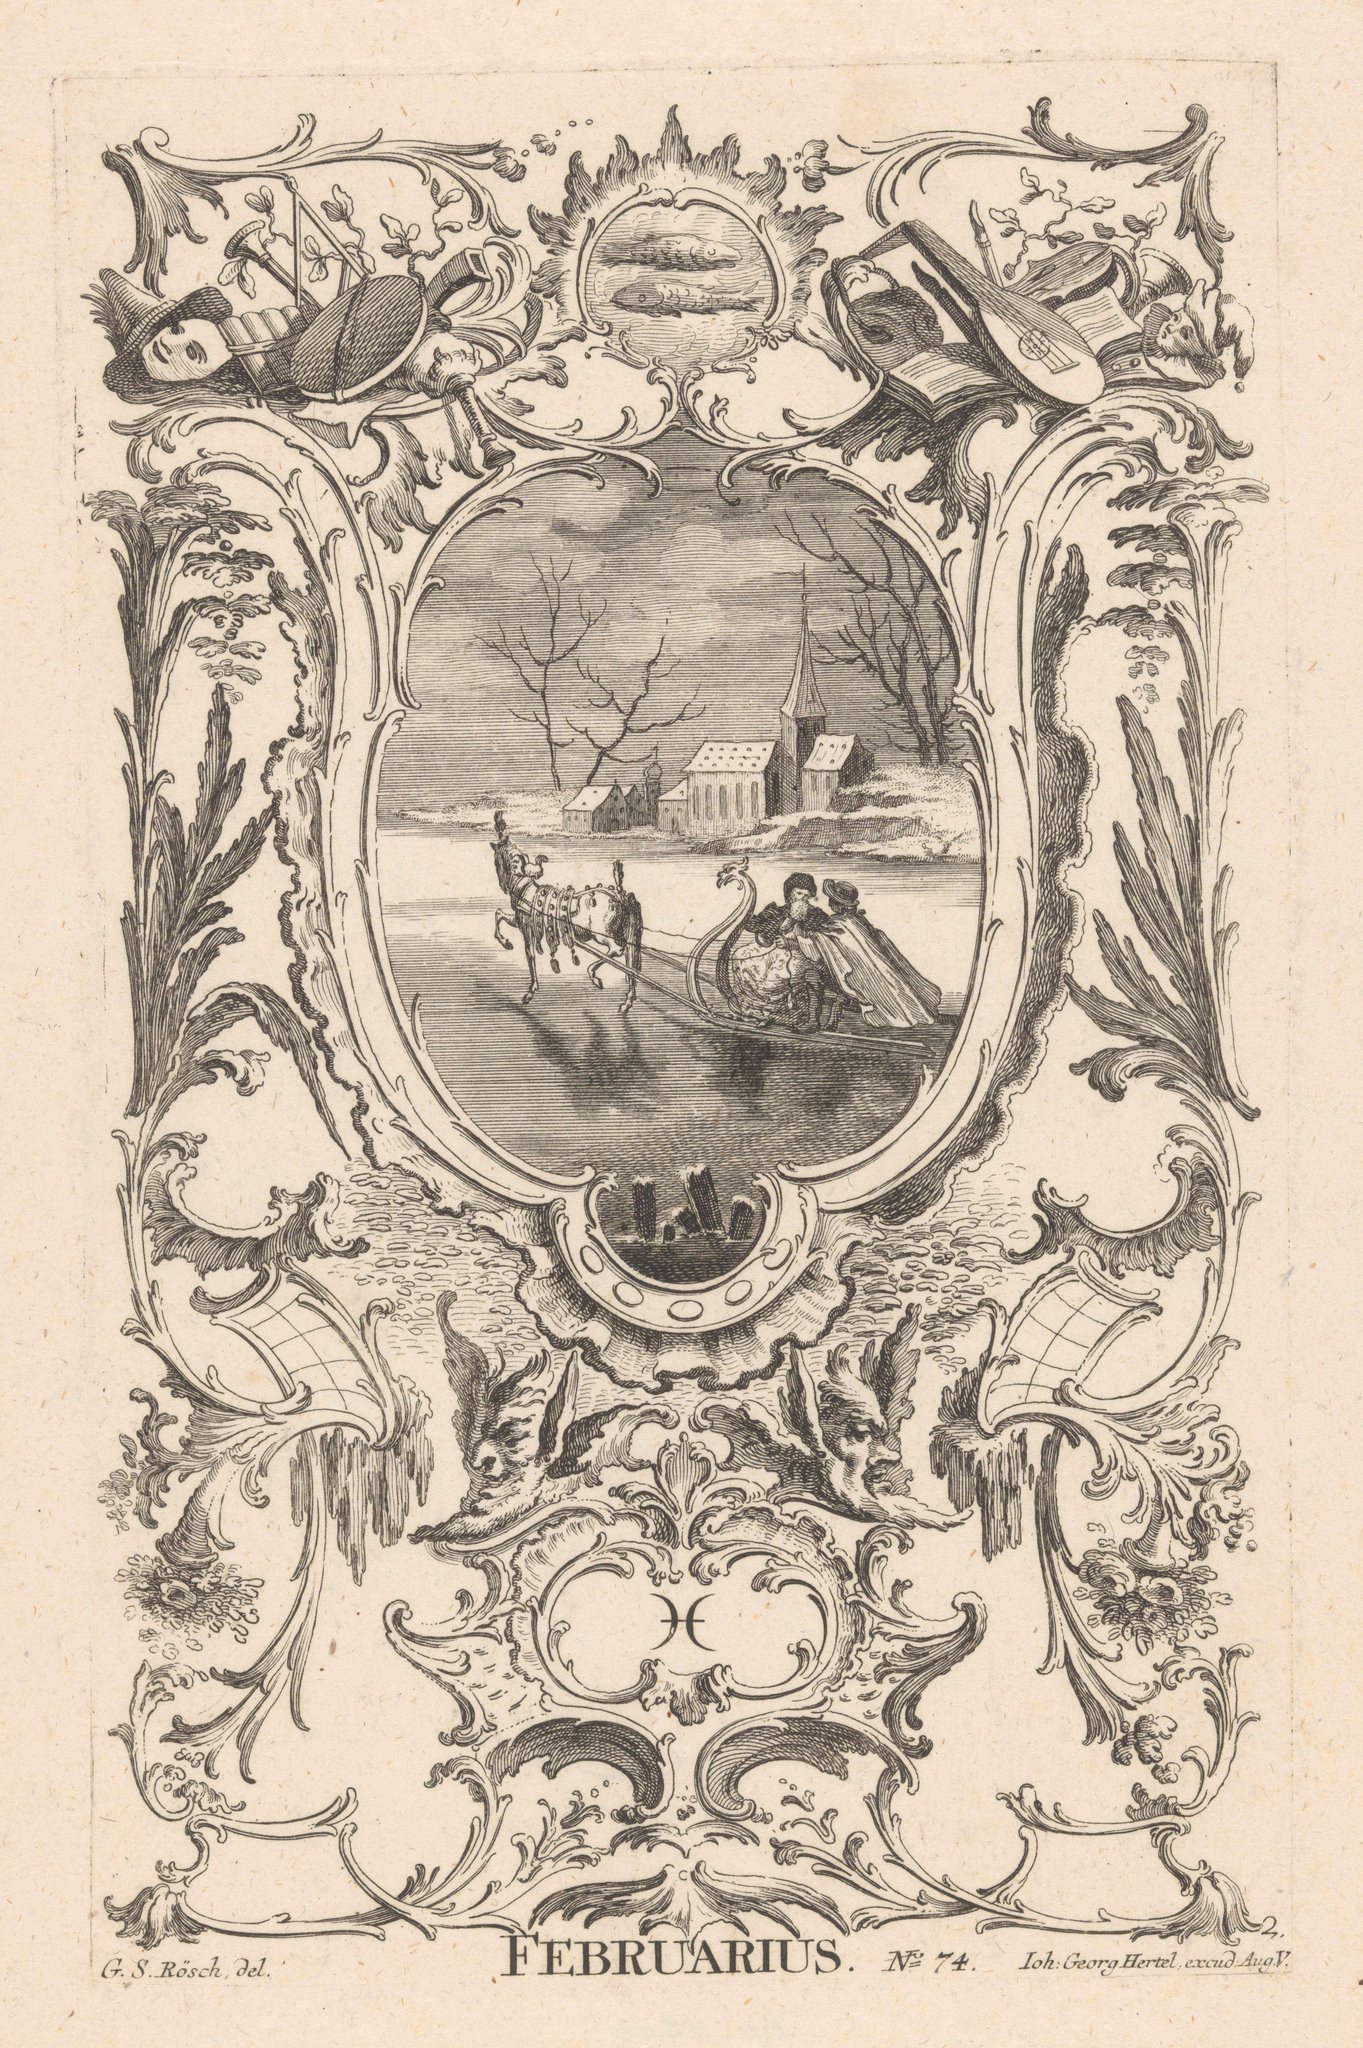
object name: print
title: Eerste zes maanden van het jaar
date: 1705-1766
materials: paper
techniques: etching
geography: augsburg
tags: horse-sleigh, february and its 'labours'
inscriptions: collector's mark: Lugt 2760, collector's mark: Lugt 2228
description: In een rocaille cartouche figuren op een arrenslee. Rondom de voorstelling rocaille ornamenten, muziekinstrumenten, vissen, het bijbehorende teken van de dierenriem en fantasiekoppen. Uitgeversnummer 74.